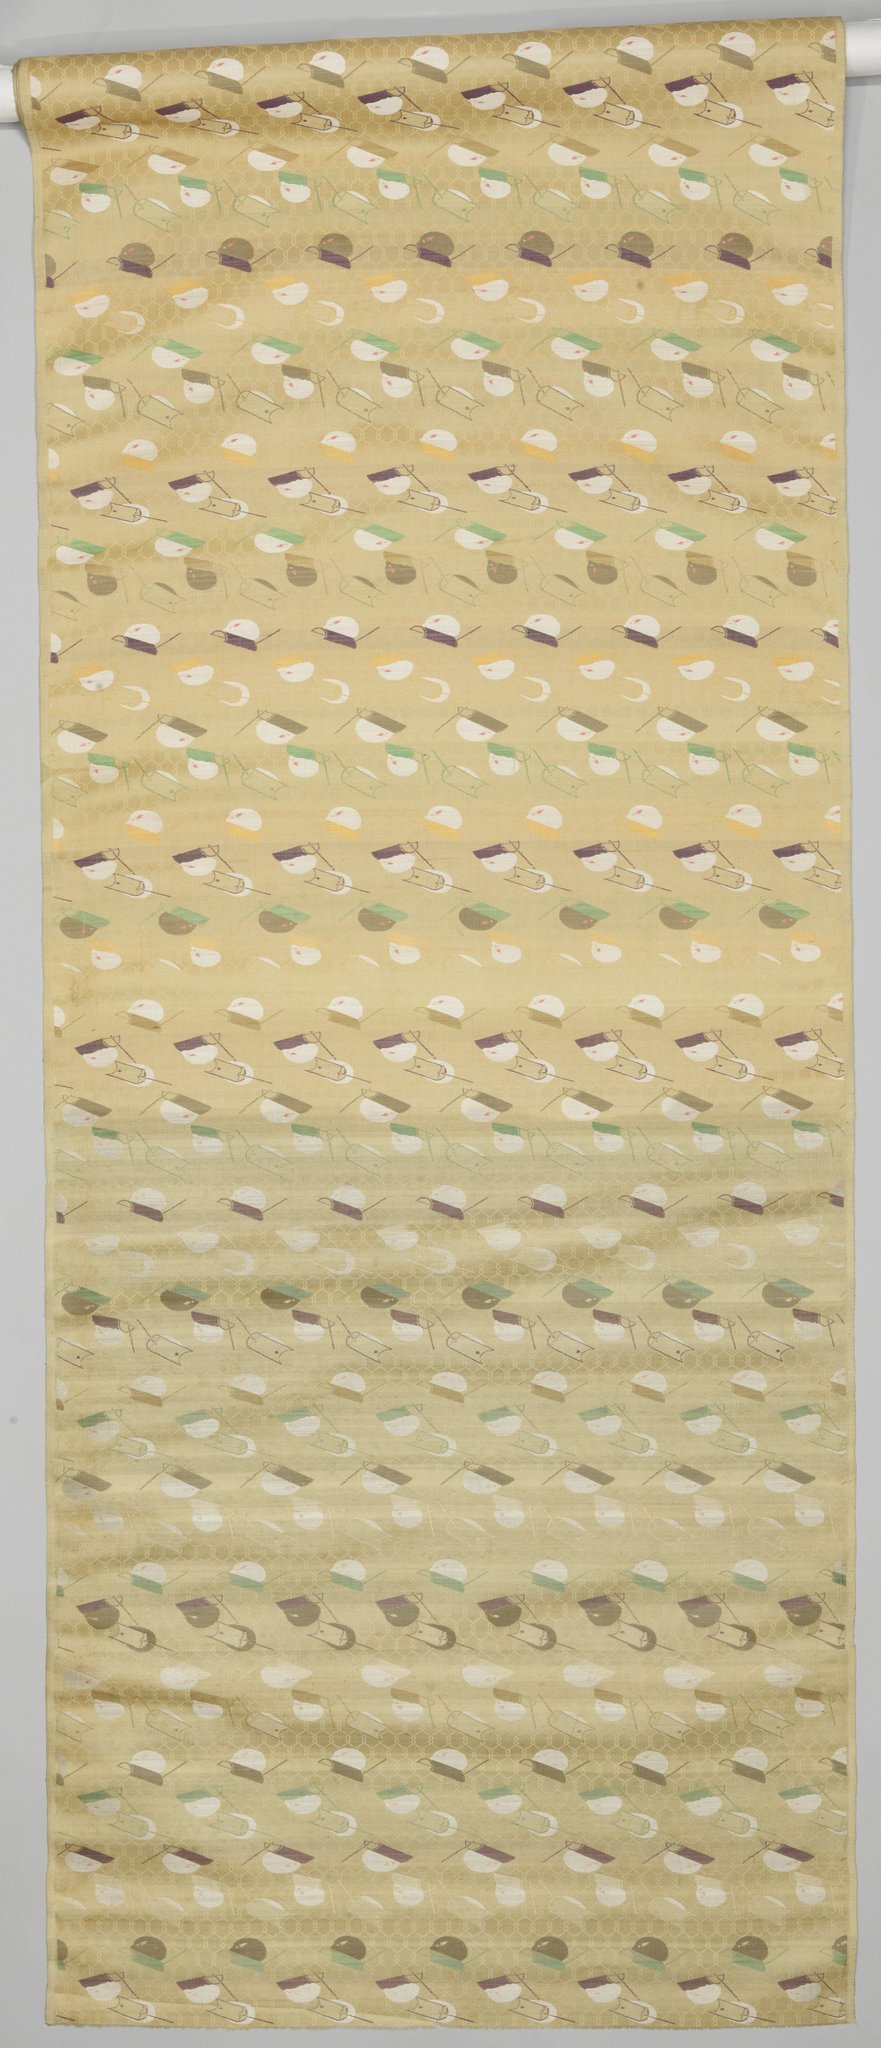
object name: textile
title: Baan zijdedamast met een dessin van geschakeld rasterwerk en banen ornament van lampionnen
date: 1900-1920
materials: silk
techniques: damask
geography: japan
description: Baan zijdedamast met een dessin van geschakeld rasterwerk in goudgeel op goudgeel fond "waaroverheen" banen met een ornament van lampionnen in groen, bruin, oranje en paars met zilverwit en rood accent. Oosterse textiel.